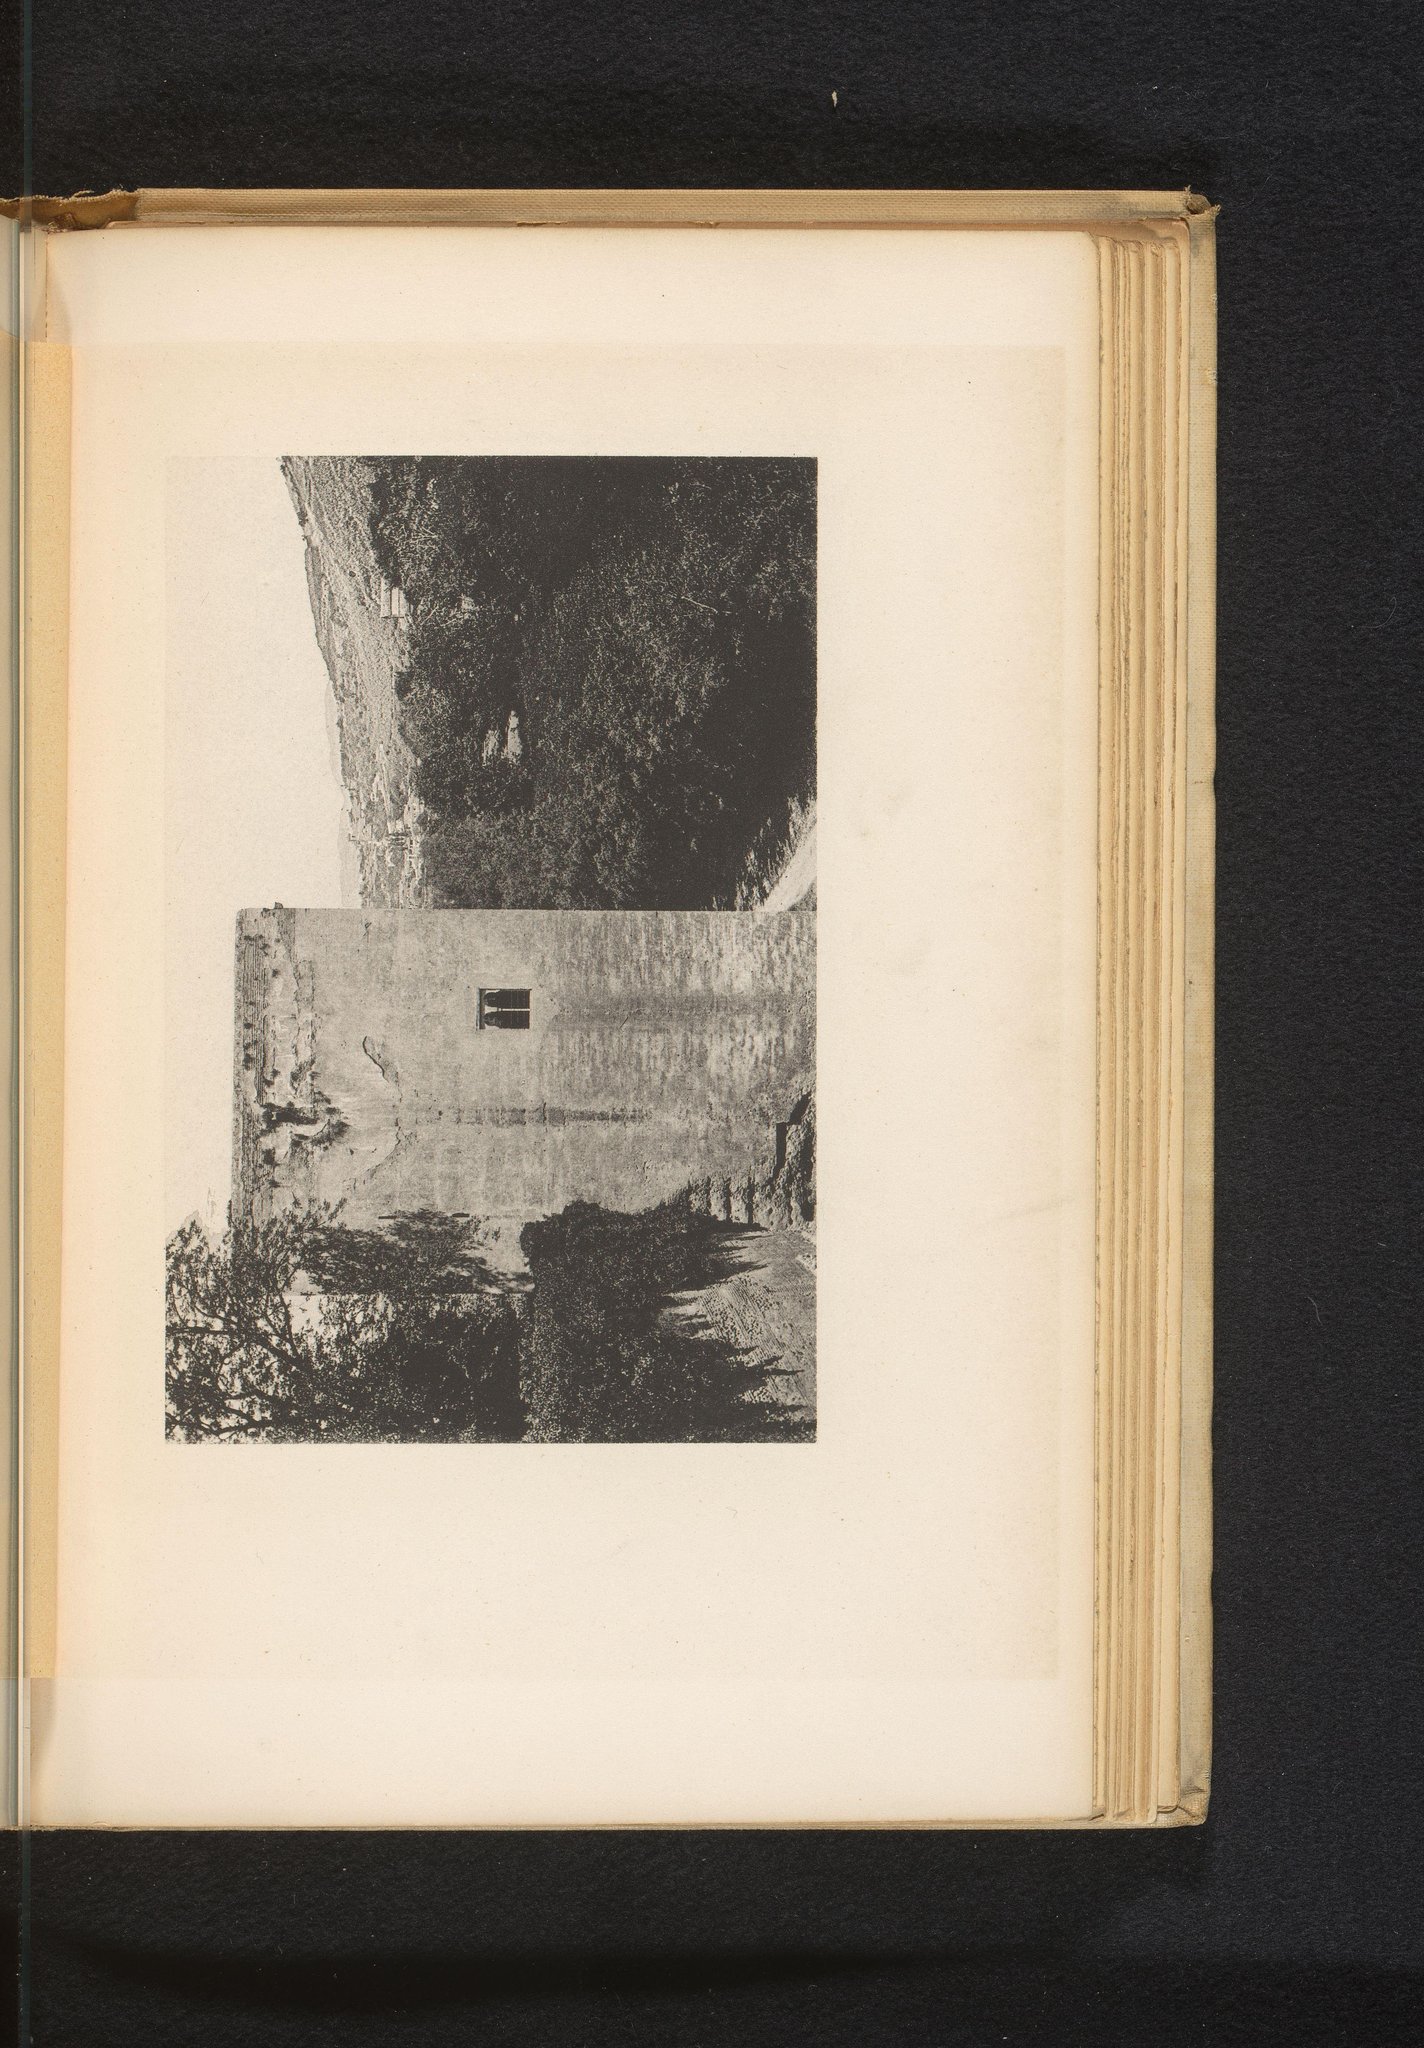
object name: photomechanical print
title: Torre de la Cautiva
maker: Anonymous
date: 1884-1894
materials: paper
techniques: photoaquatint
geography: alhambra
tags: tower, clock tower ~ monumental adornment